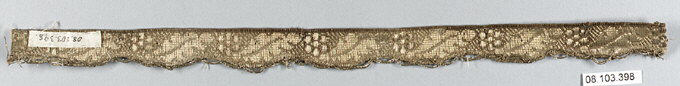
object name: galloon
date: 1701-1900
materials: metal thread